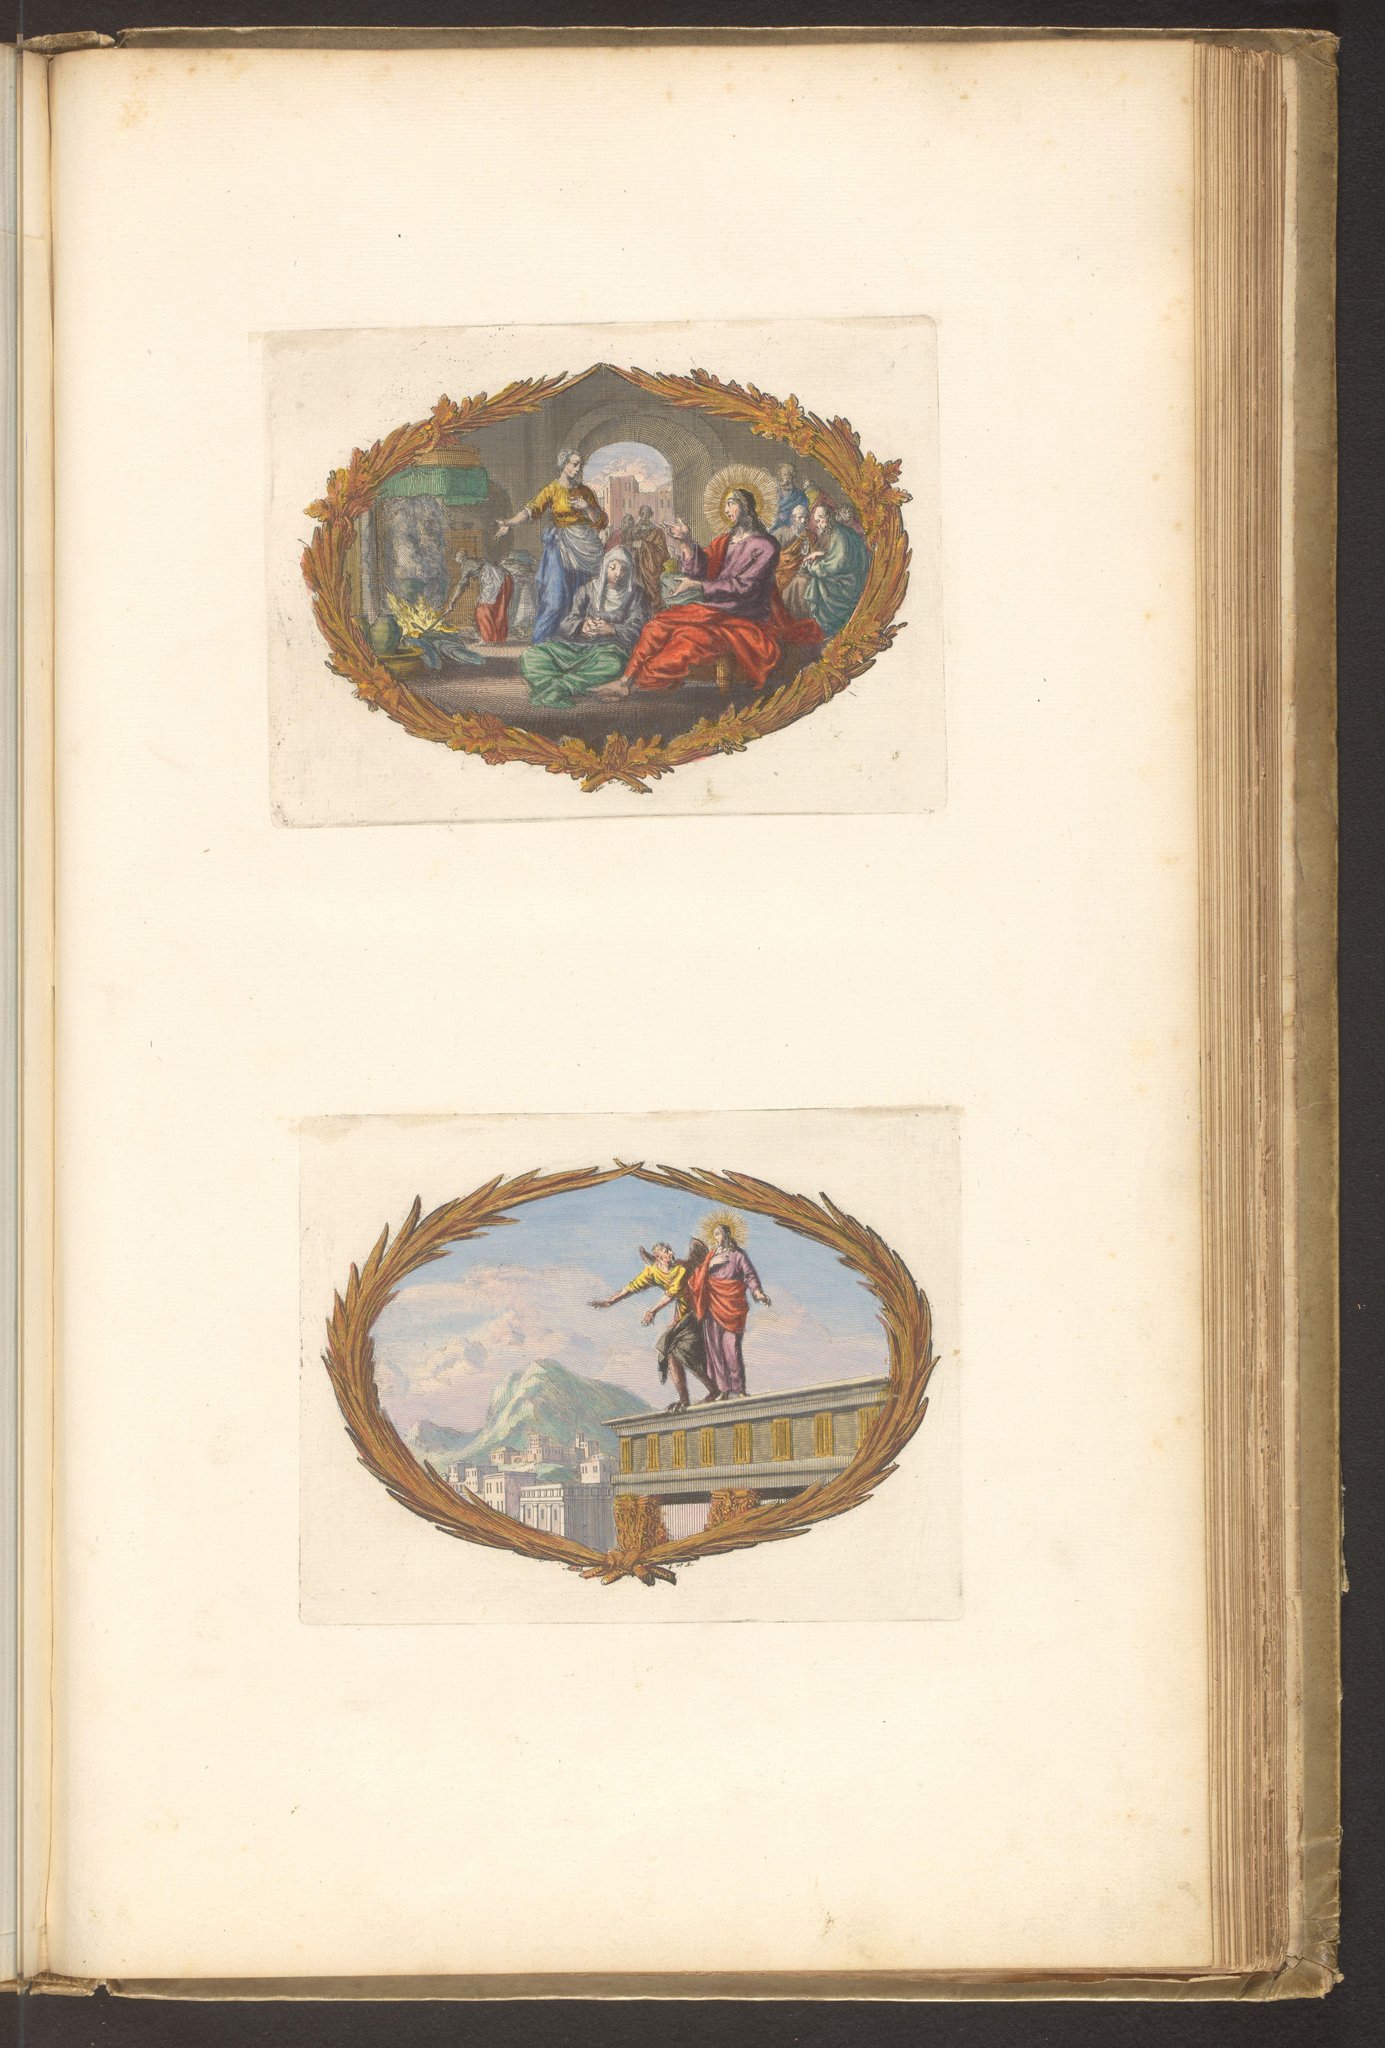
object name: print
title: Blad met twee vignetten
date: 1700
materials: paint, paper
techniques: etching, hand coloring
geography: amsterdam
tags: 'throw yourself down' (from the temple) ~ temptation of christ in the wilderness, christ in the house of martha and mary (luke 10:38-42)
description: Blad met twee vignetten tussen palmtakken. Boven: Christus in het huis van Martha en Maria. Onder: Verzoeking van Christus door de duivel op de tempel. Blad in het tweede deel van de prentbijbel met het Nieuwe Testament, uitgegeven door Pieter Mortier, Amsterdam 1700.